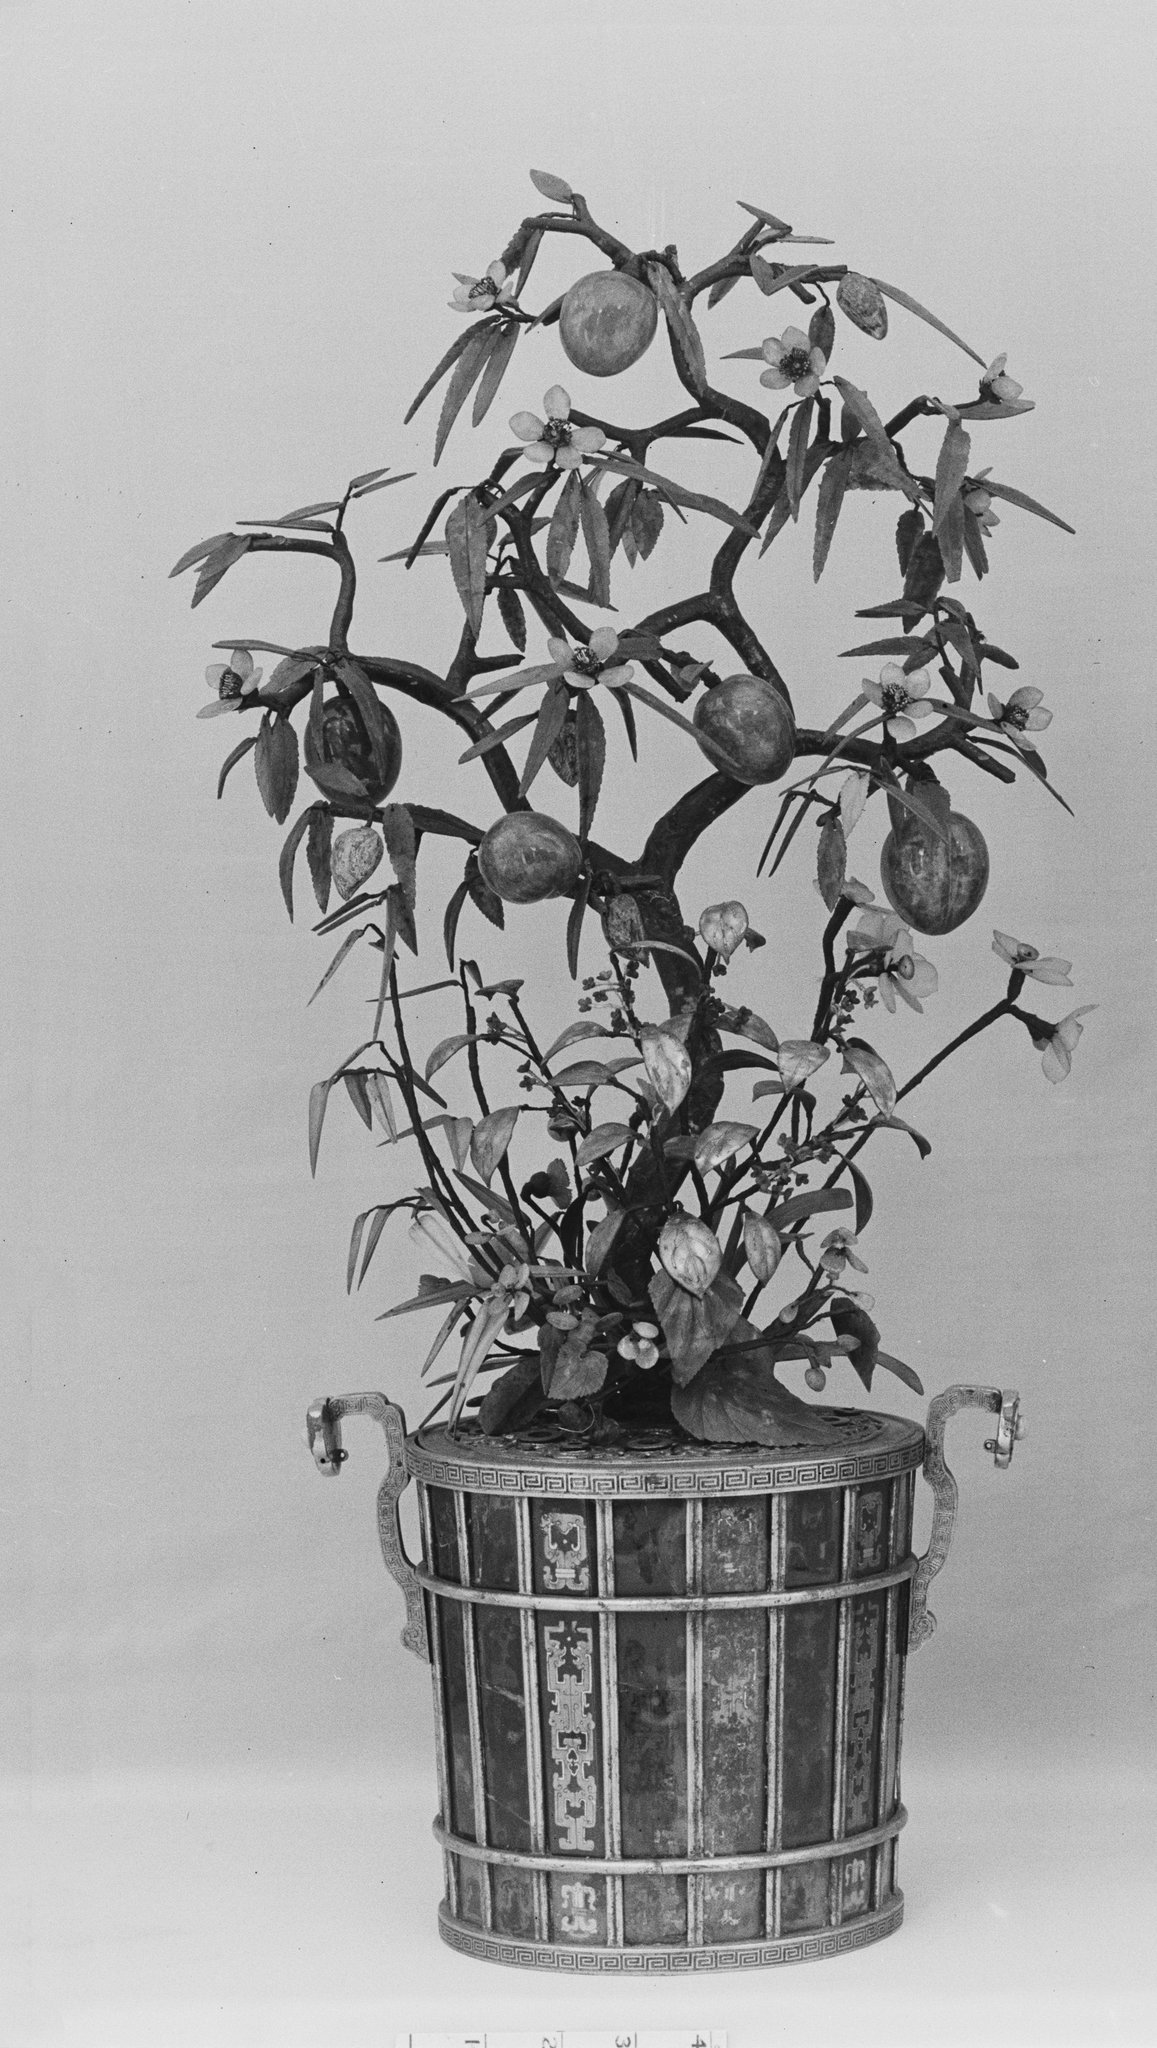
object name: pot with plant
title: Pot with Flowering Plant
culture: chinese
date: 1796-1820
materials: jade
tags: fruit,flowers